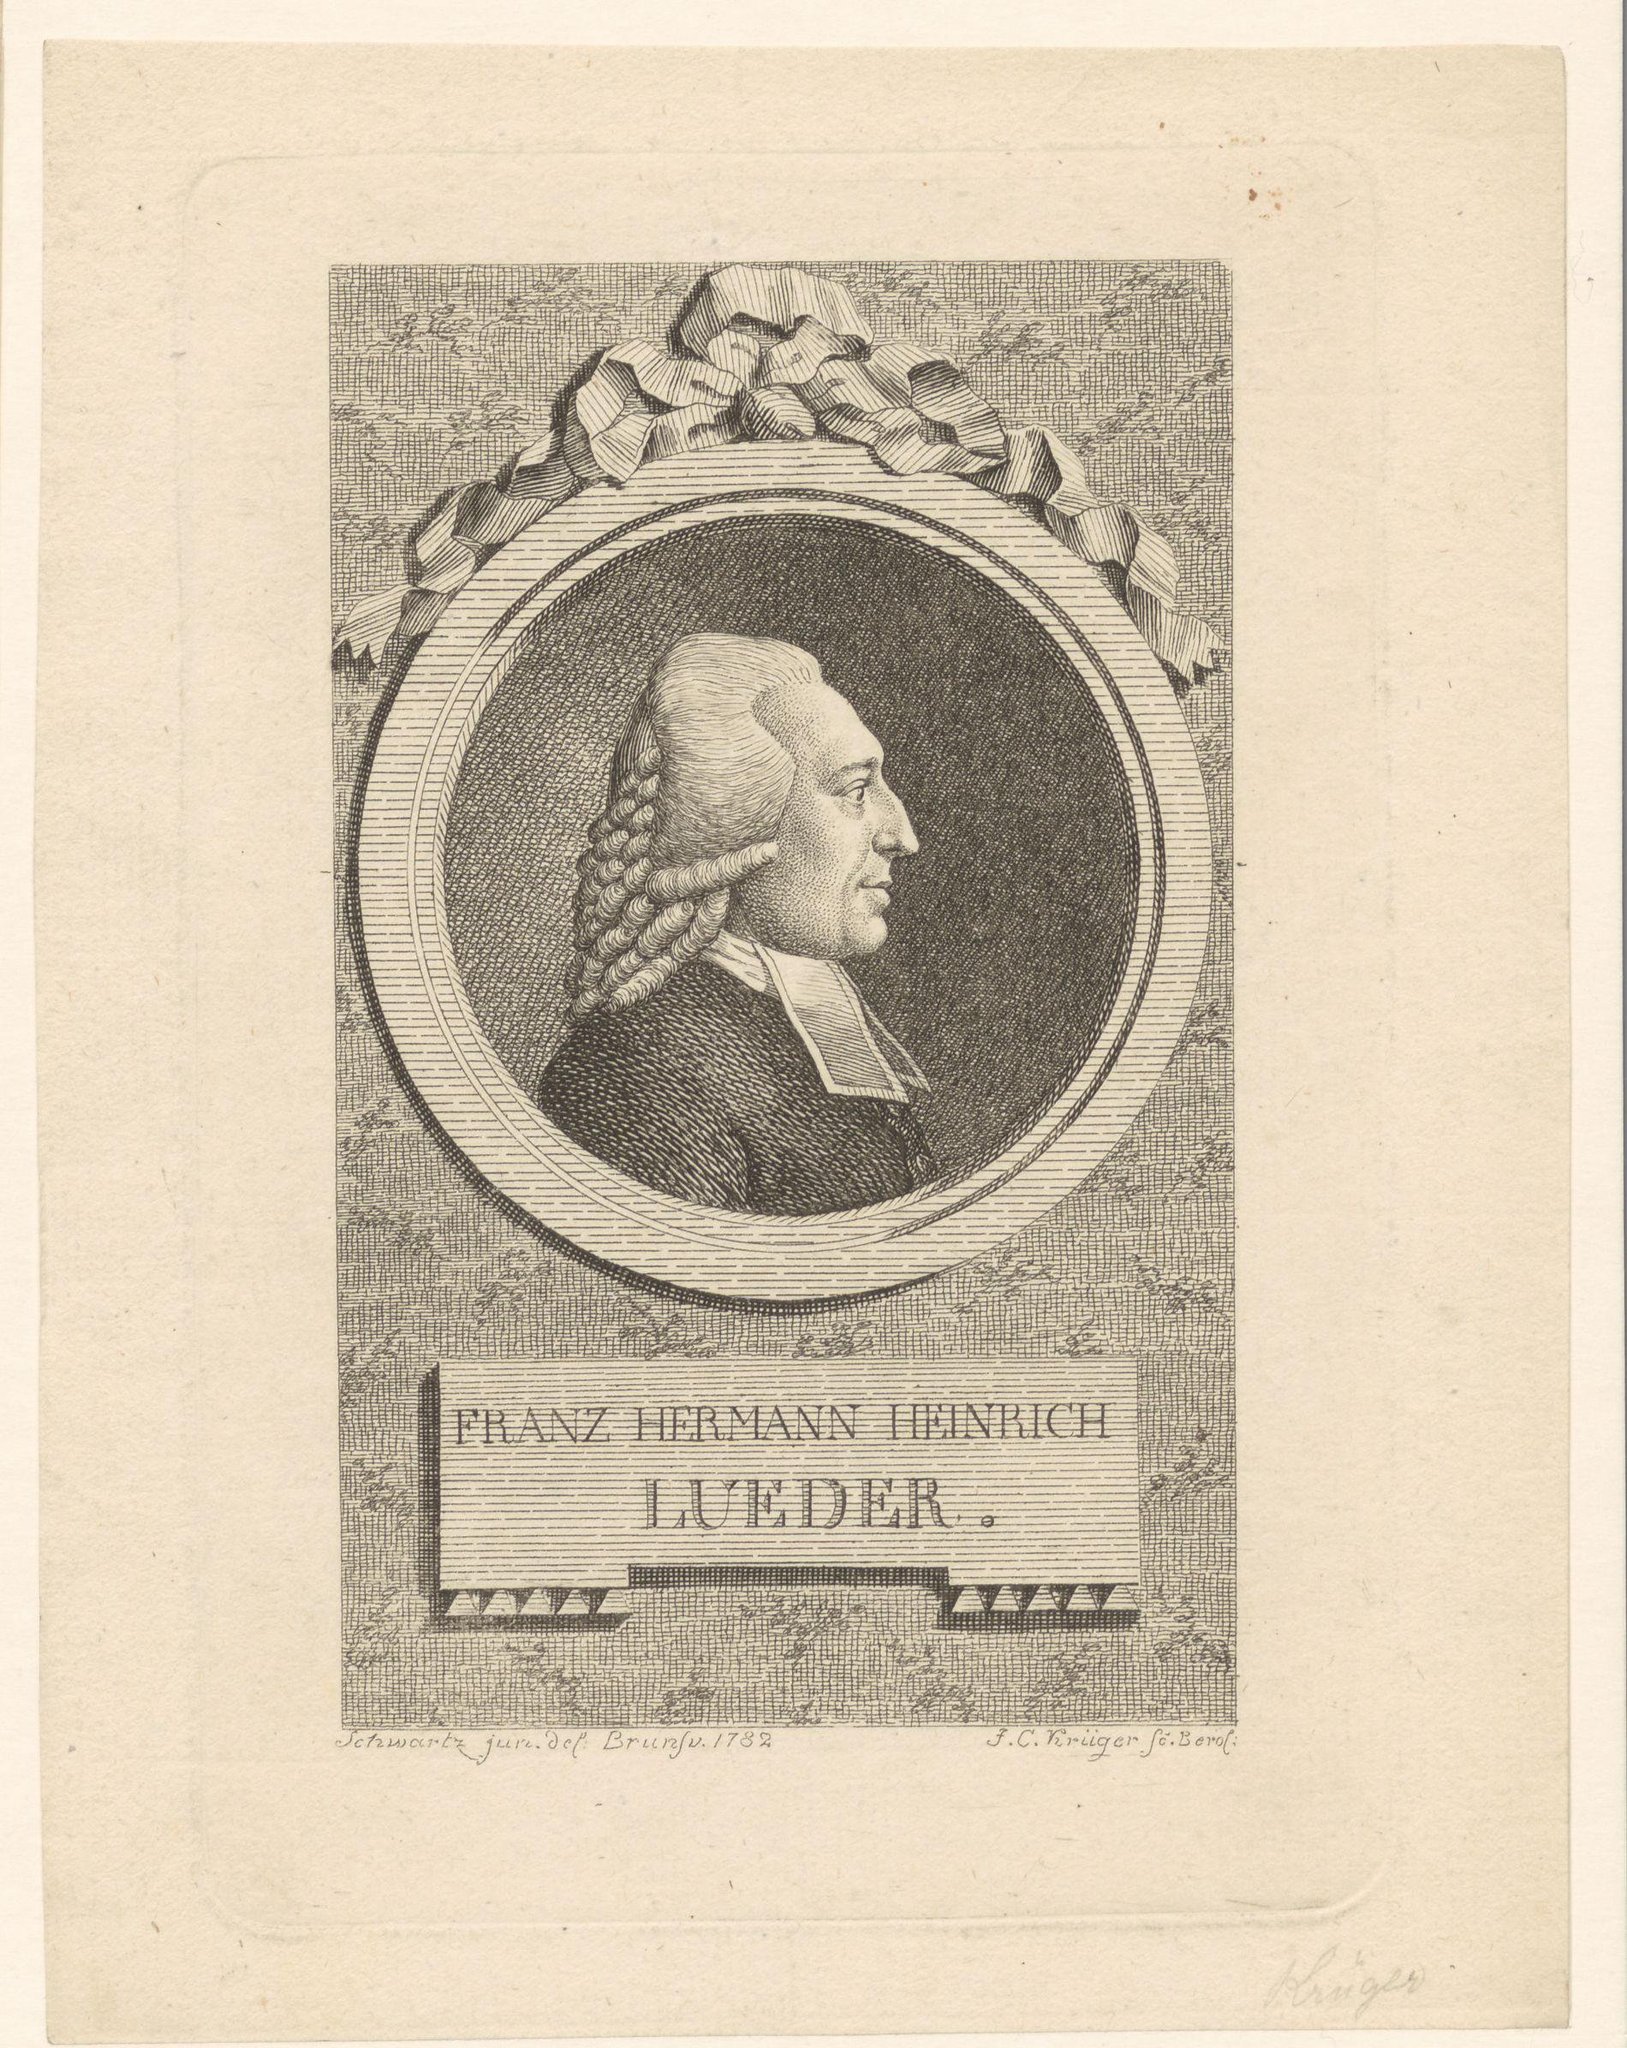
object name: print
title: Portret van Franz Hermann Heinrich Lueder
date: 1782-1791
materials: paper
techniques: engraving, etching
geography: braunschweig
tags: theologian, botany (+ portrait of scholar, scientist), historical persons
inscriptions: collector's mark: Lugt 2228